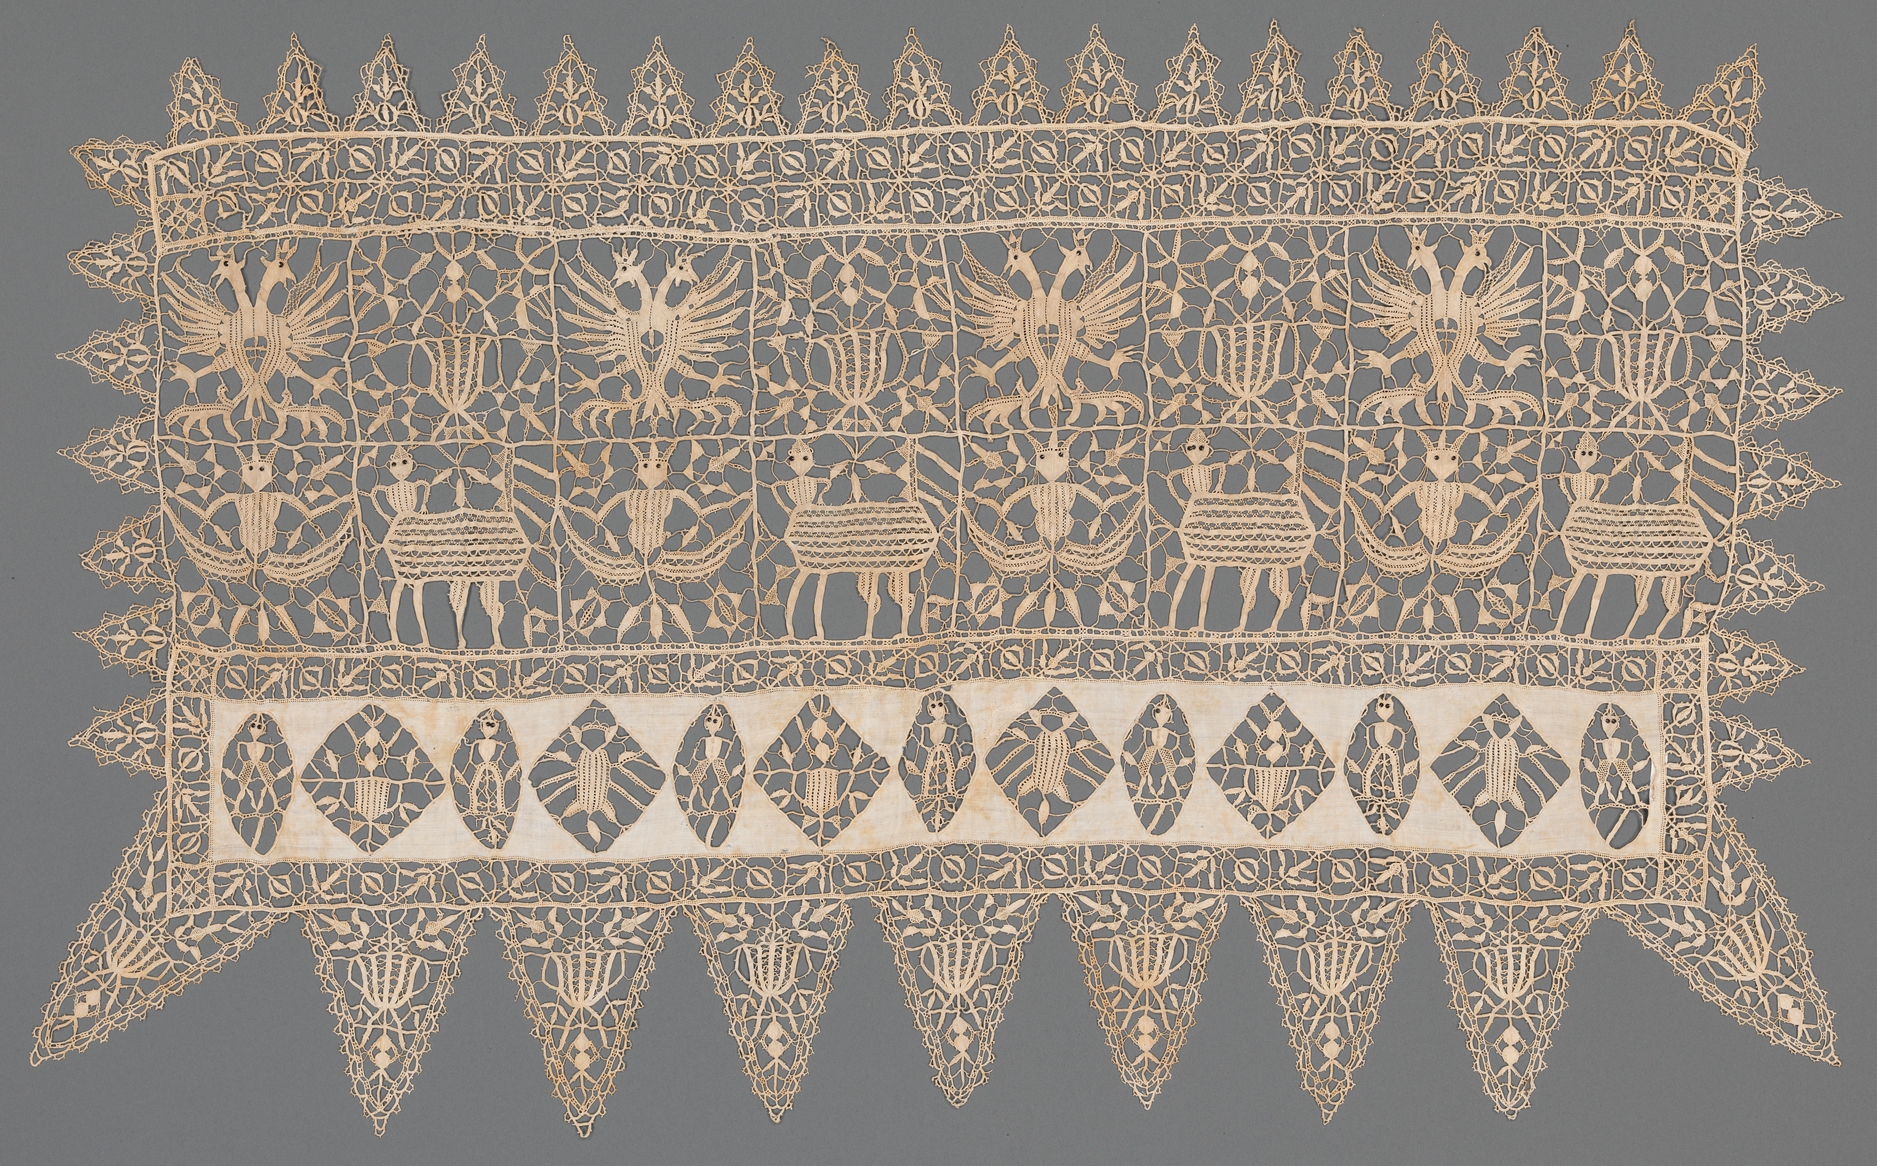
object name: cover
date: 1600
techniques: lace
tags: human figures,birds